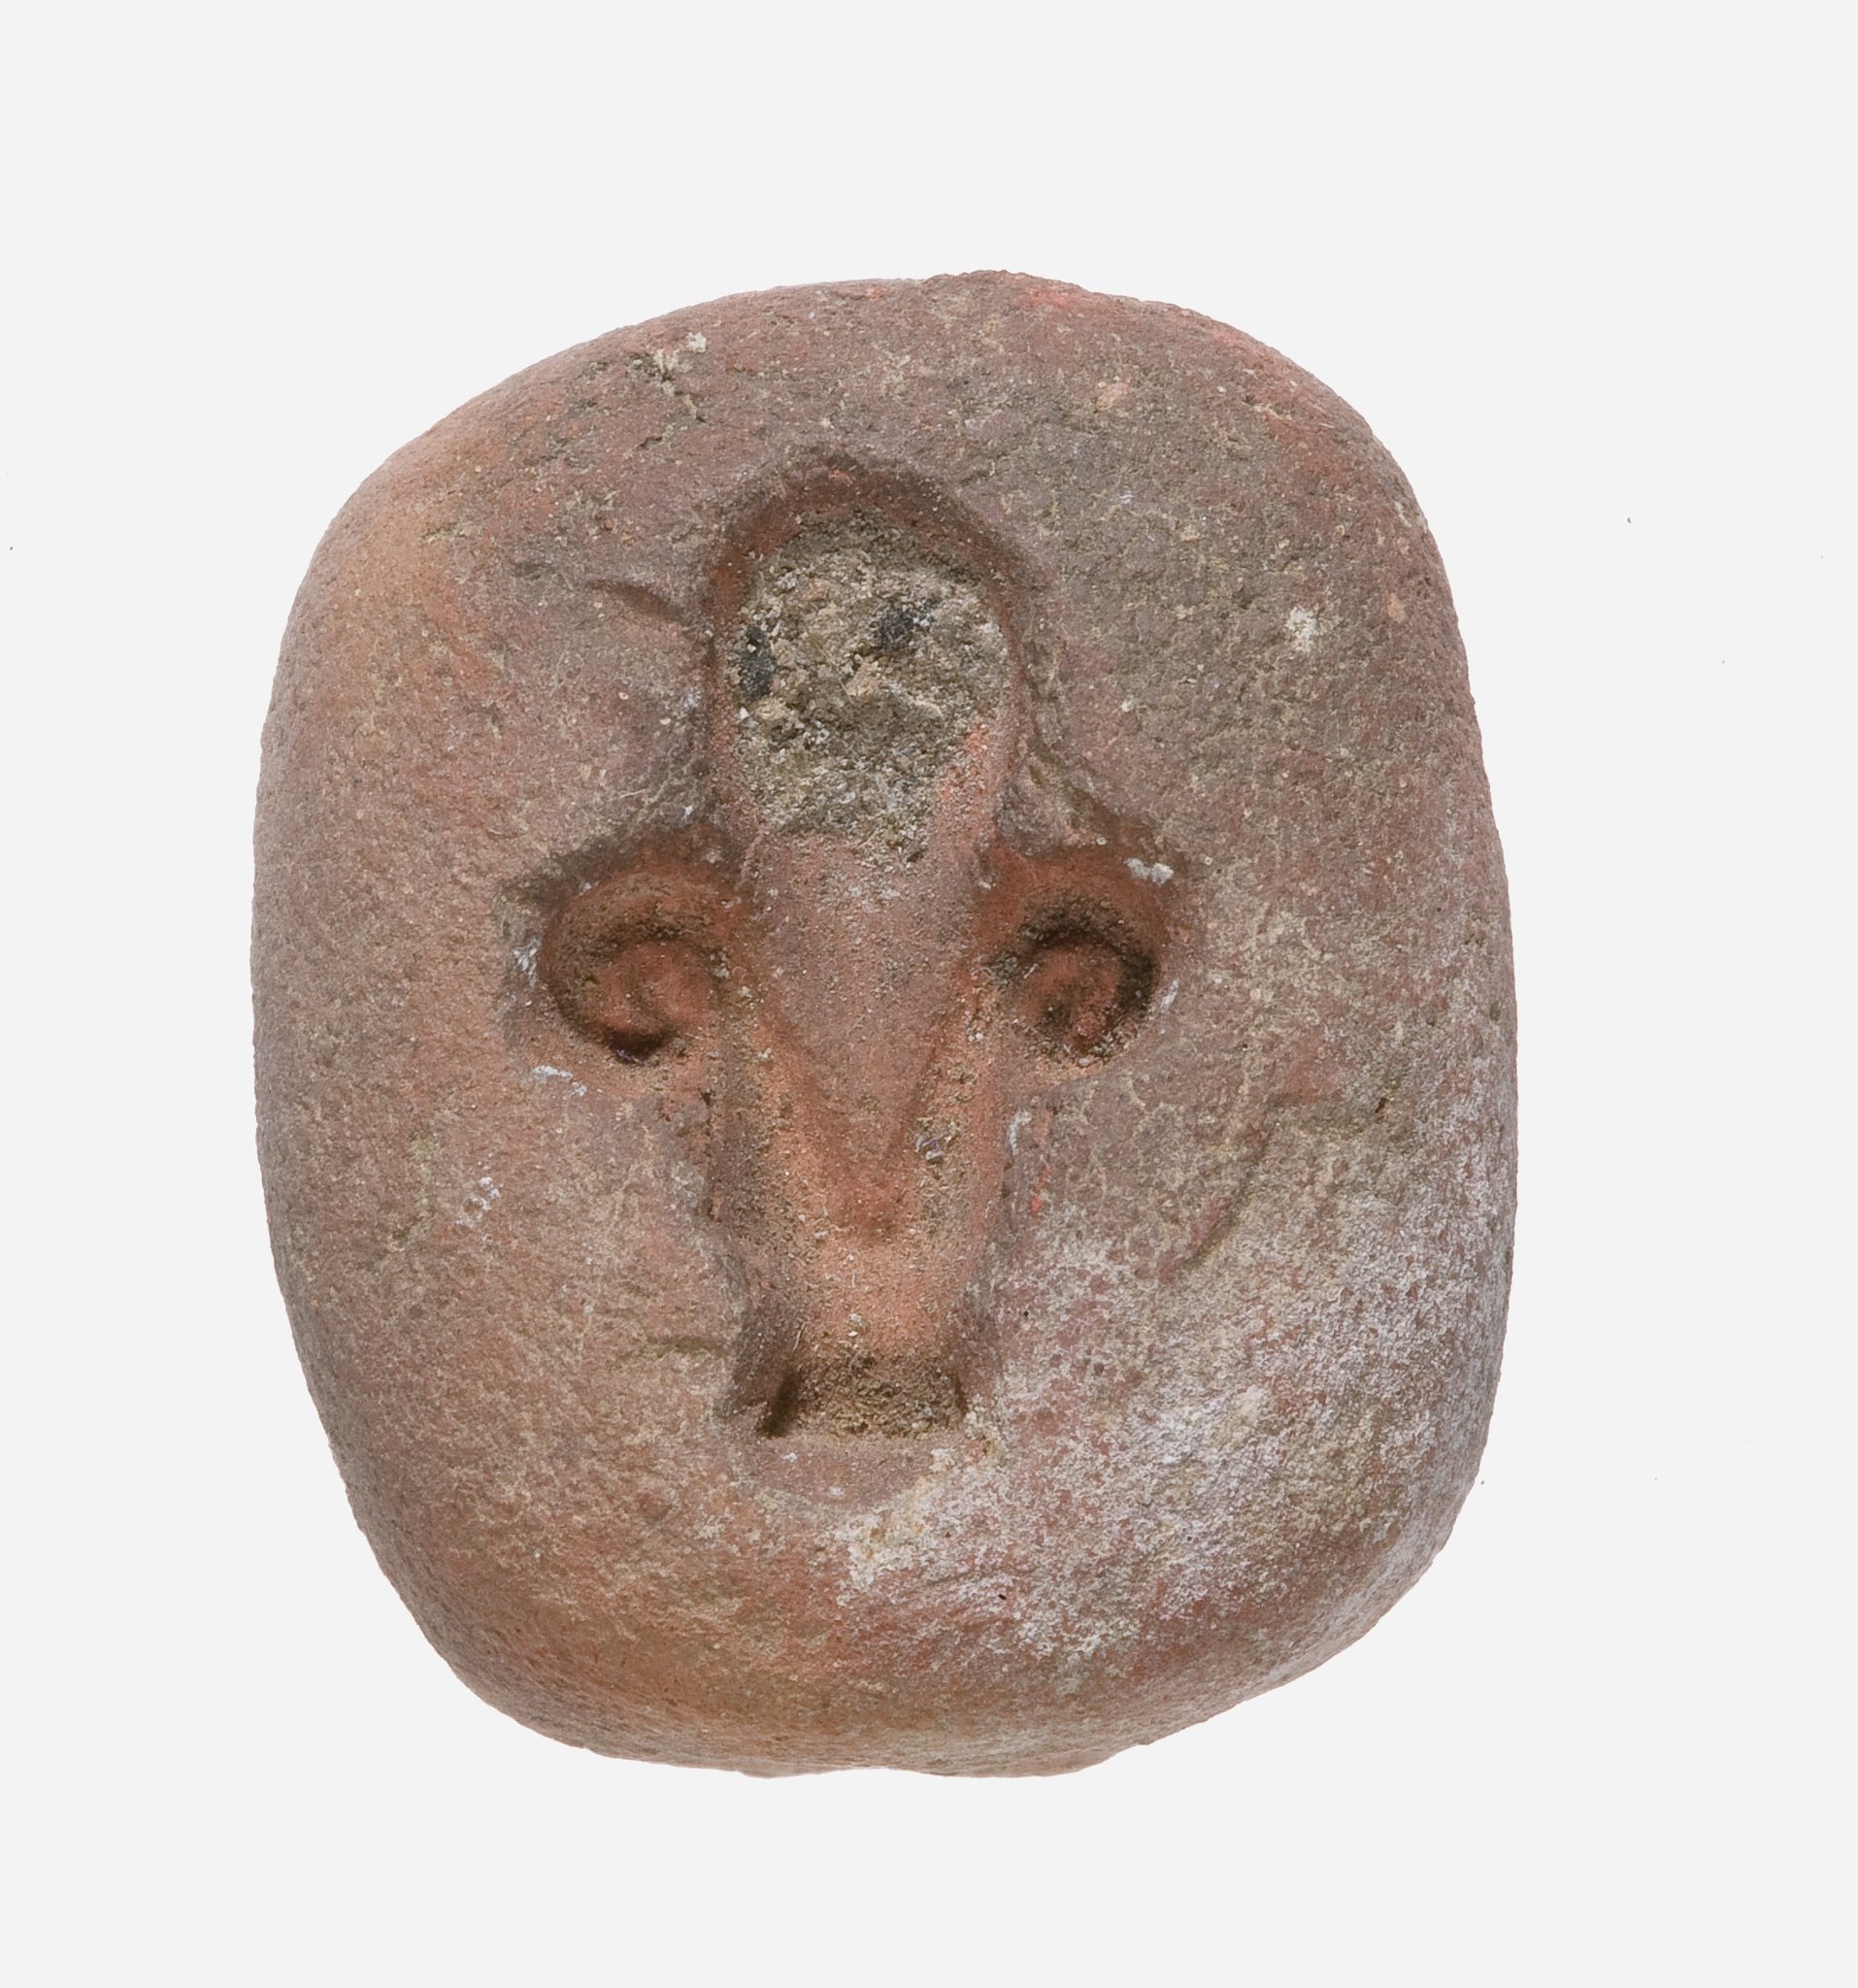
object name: mold, bead, lily petal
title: Mold for a Lily Bead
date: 1390-1352 BCE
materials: pottery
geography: egypt